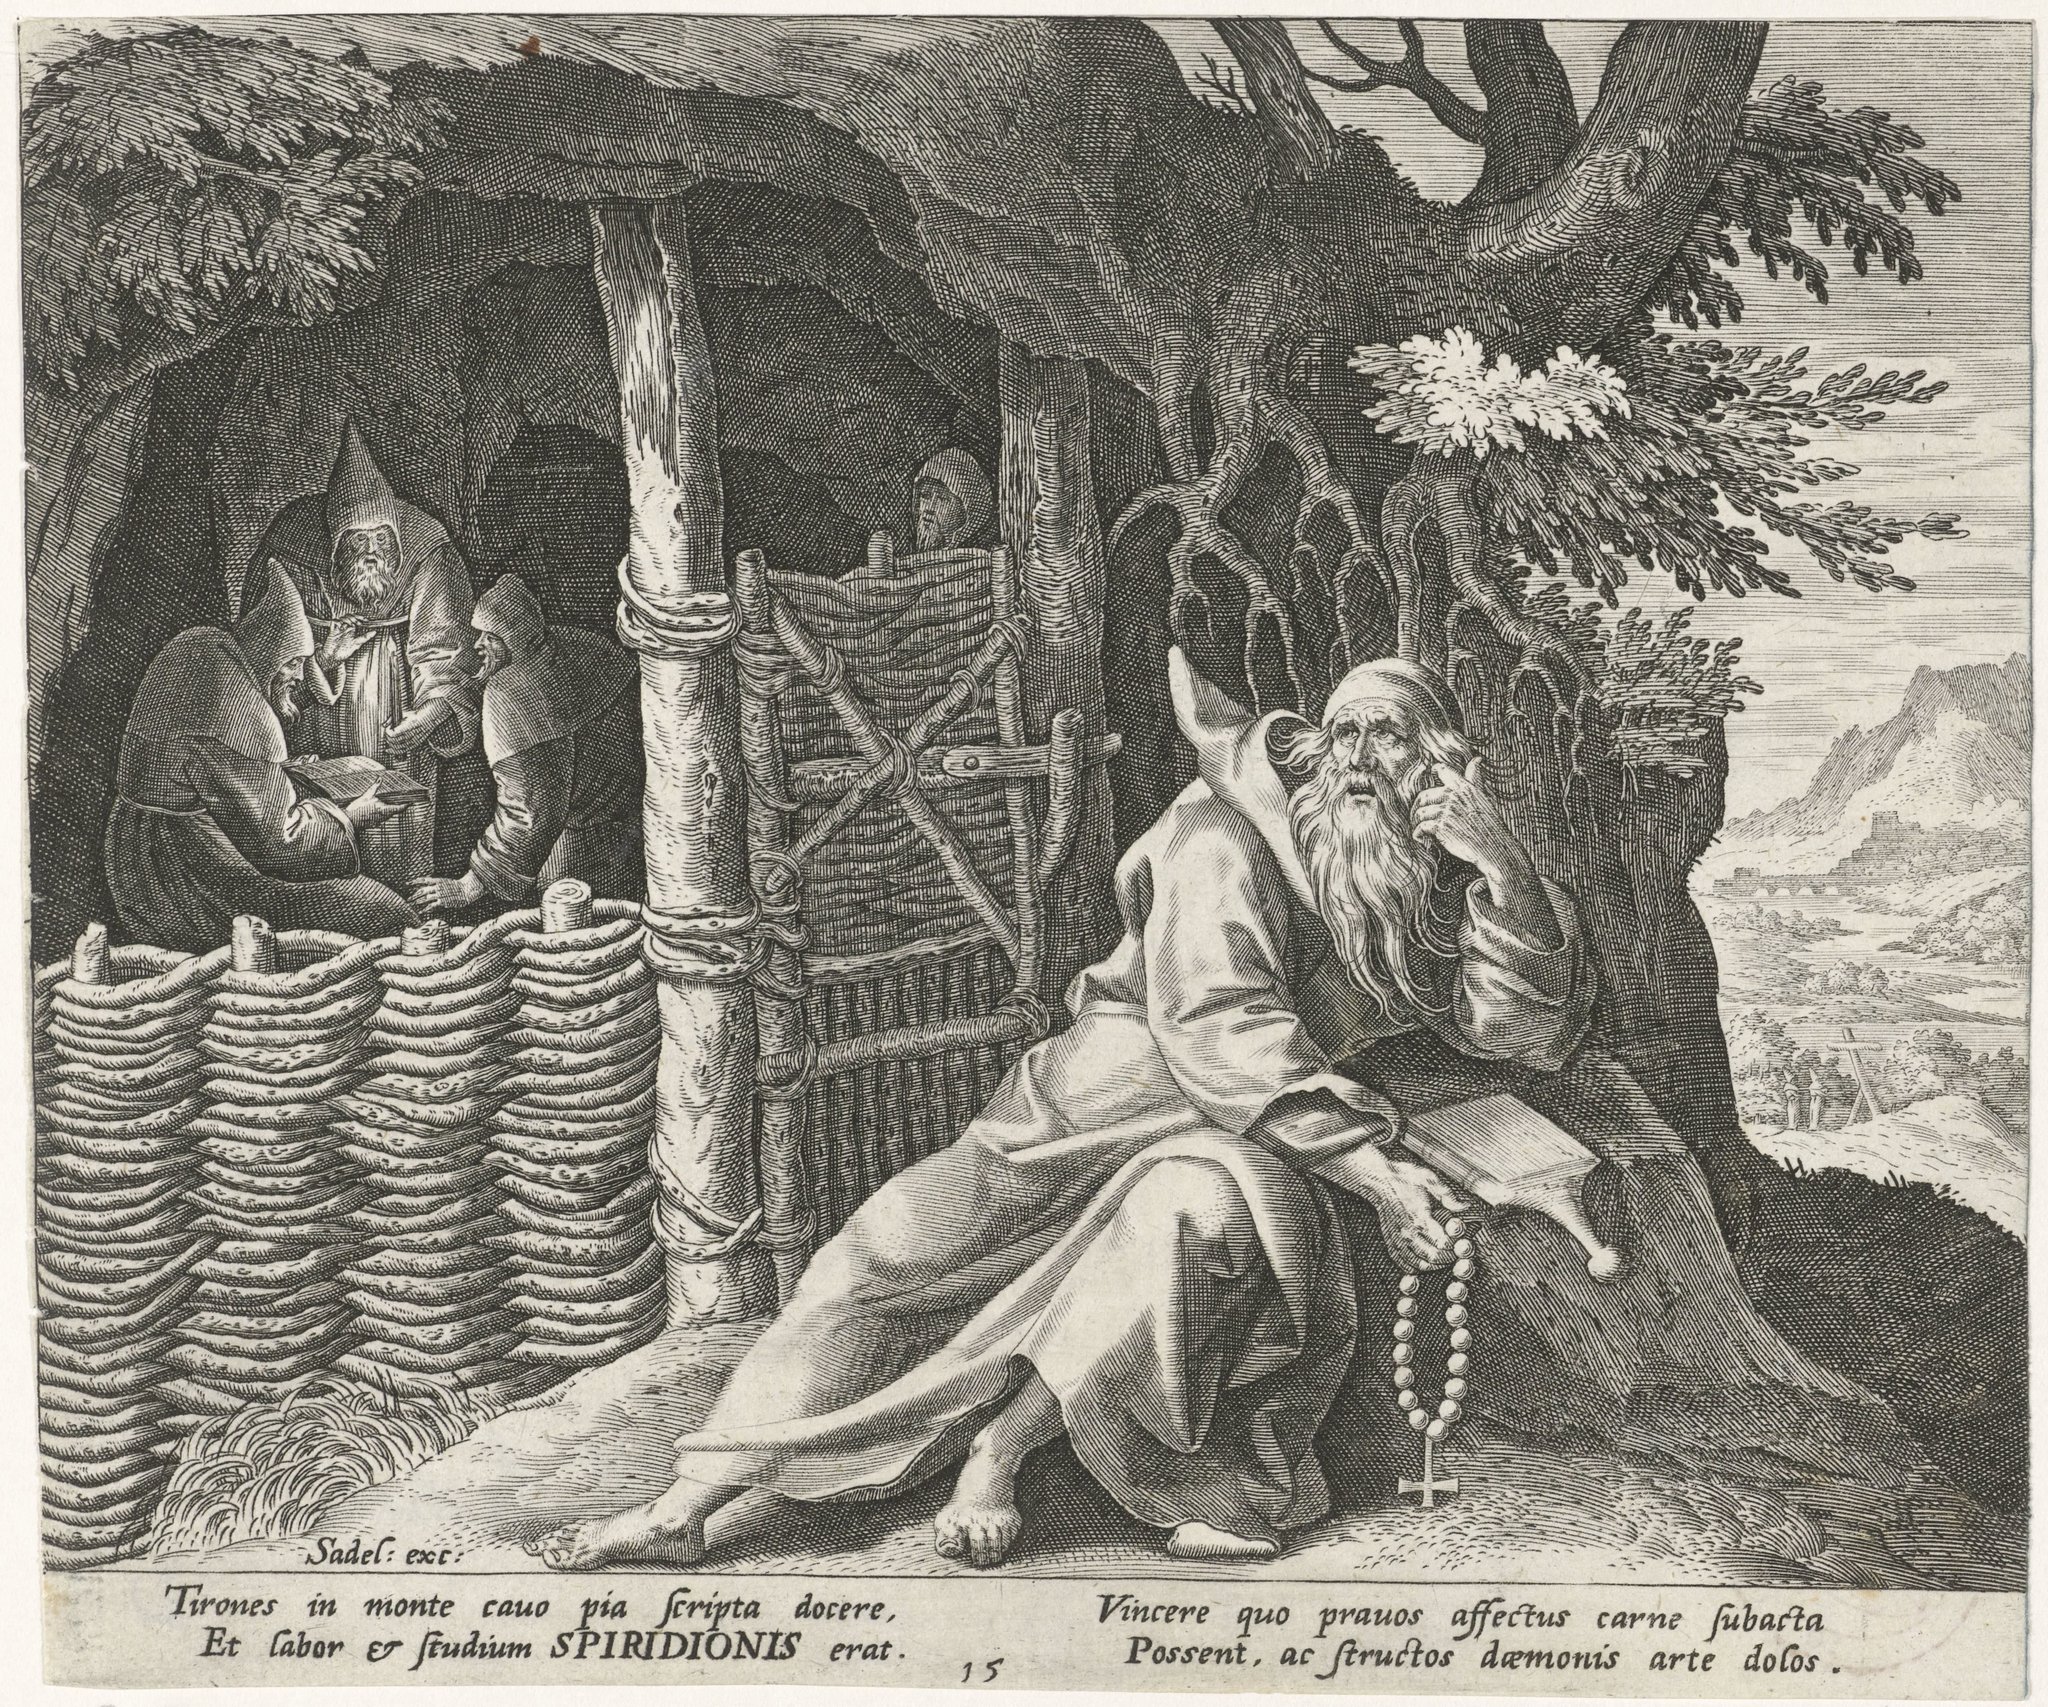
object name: print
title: Spiridon van Cyprus als kluizenaar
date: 1583-1588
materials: paper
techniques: engraving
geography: antwerp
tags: male saints (with name), anchorite, hermit, cave, grotto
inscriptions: collector's mark: Lugt 240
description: De H. Spiridon van Cyprus voor een grot in de woestijn. Hij ligt tegen een rots en leest een bijbel. In de grot lezen drie monniken uit een bijbel.